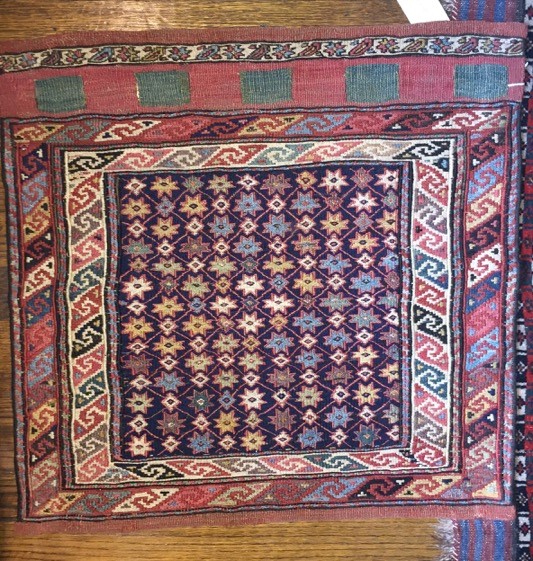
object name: saddle bag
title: Shahsevan Saddle Bag Face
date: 1870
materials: cotton, wool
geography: iran